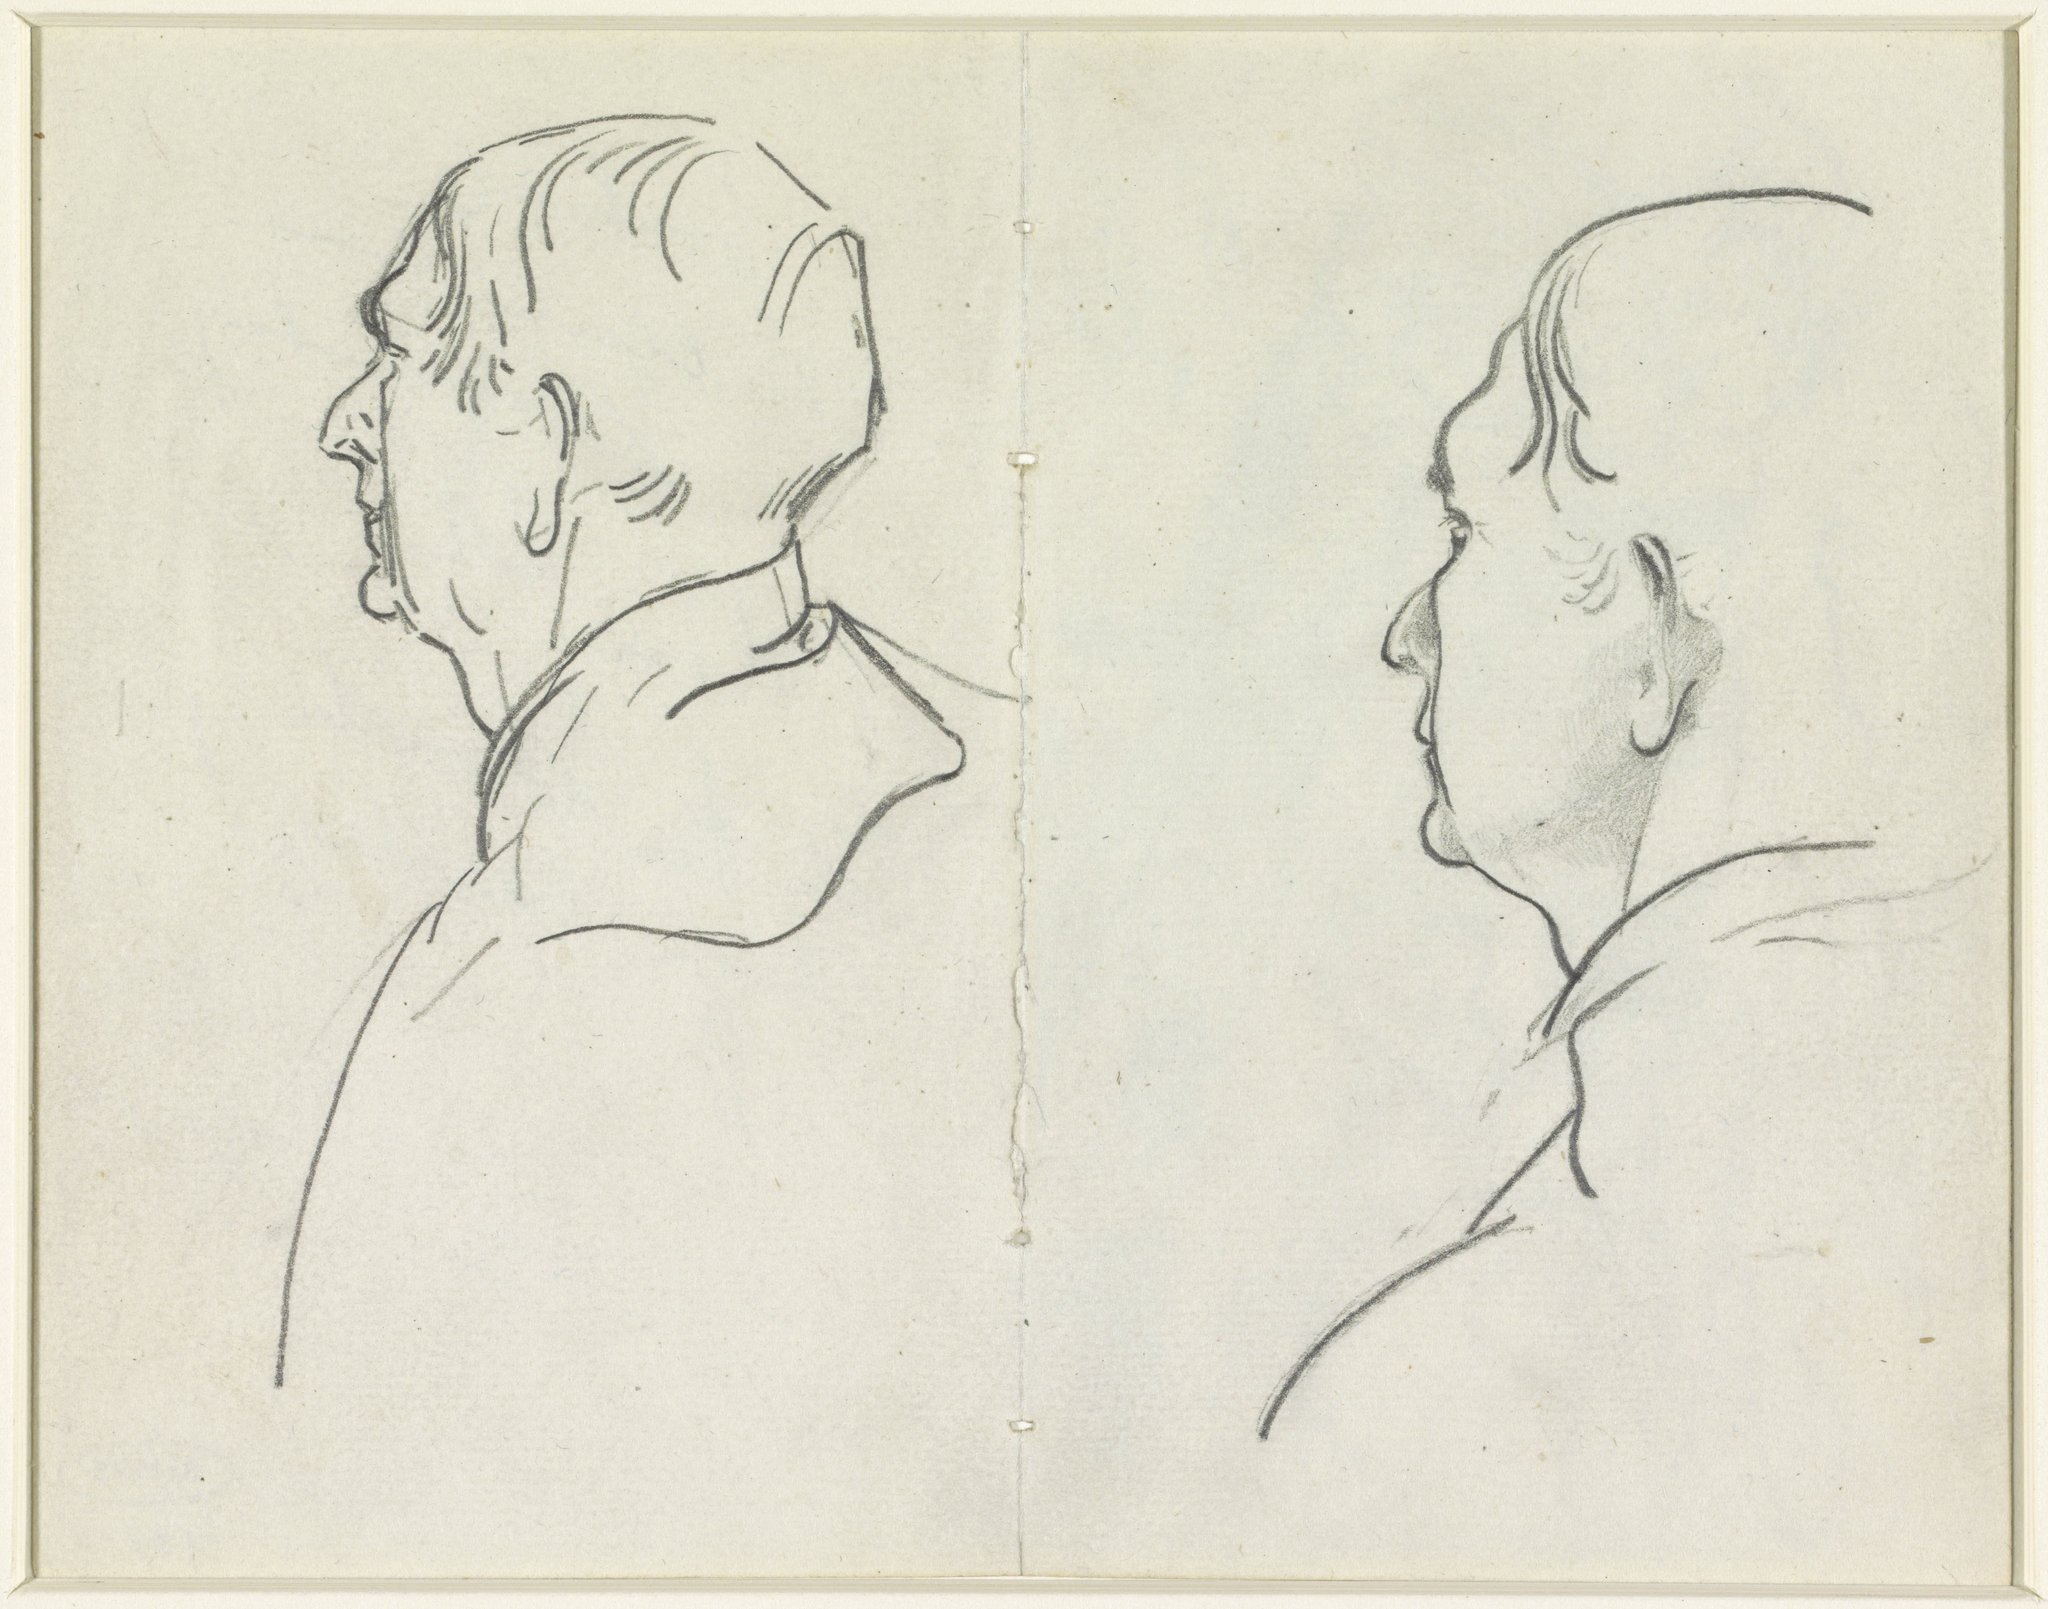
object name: drawing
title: Twee portretten van Willem van Konijnenburg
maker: johannes frederik engelbert ten klooster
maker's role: draughtsman, print maker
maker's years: 1873-1940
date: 1883-1940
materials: paper, pencil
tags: the hague, painter, willem van konijnenburg, historical persons, portrait, self-portrait of painter, portrait, self-portrait of artist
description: Twee portretten van Willem van Konijnenburg, uit een schetsboekje.